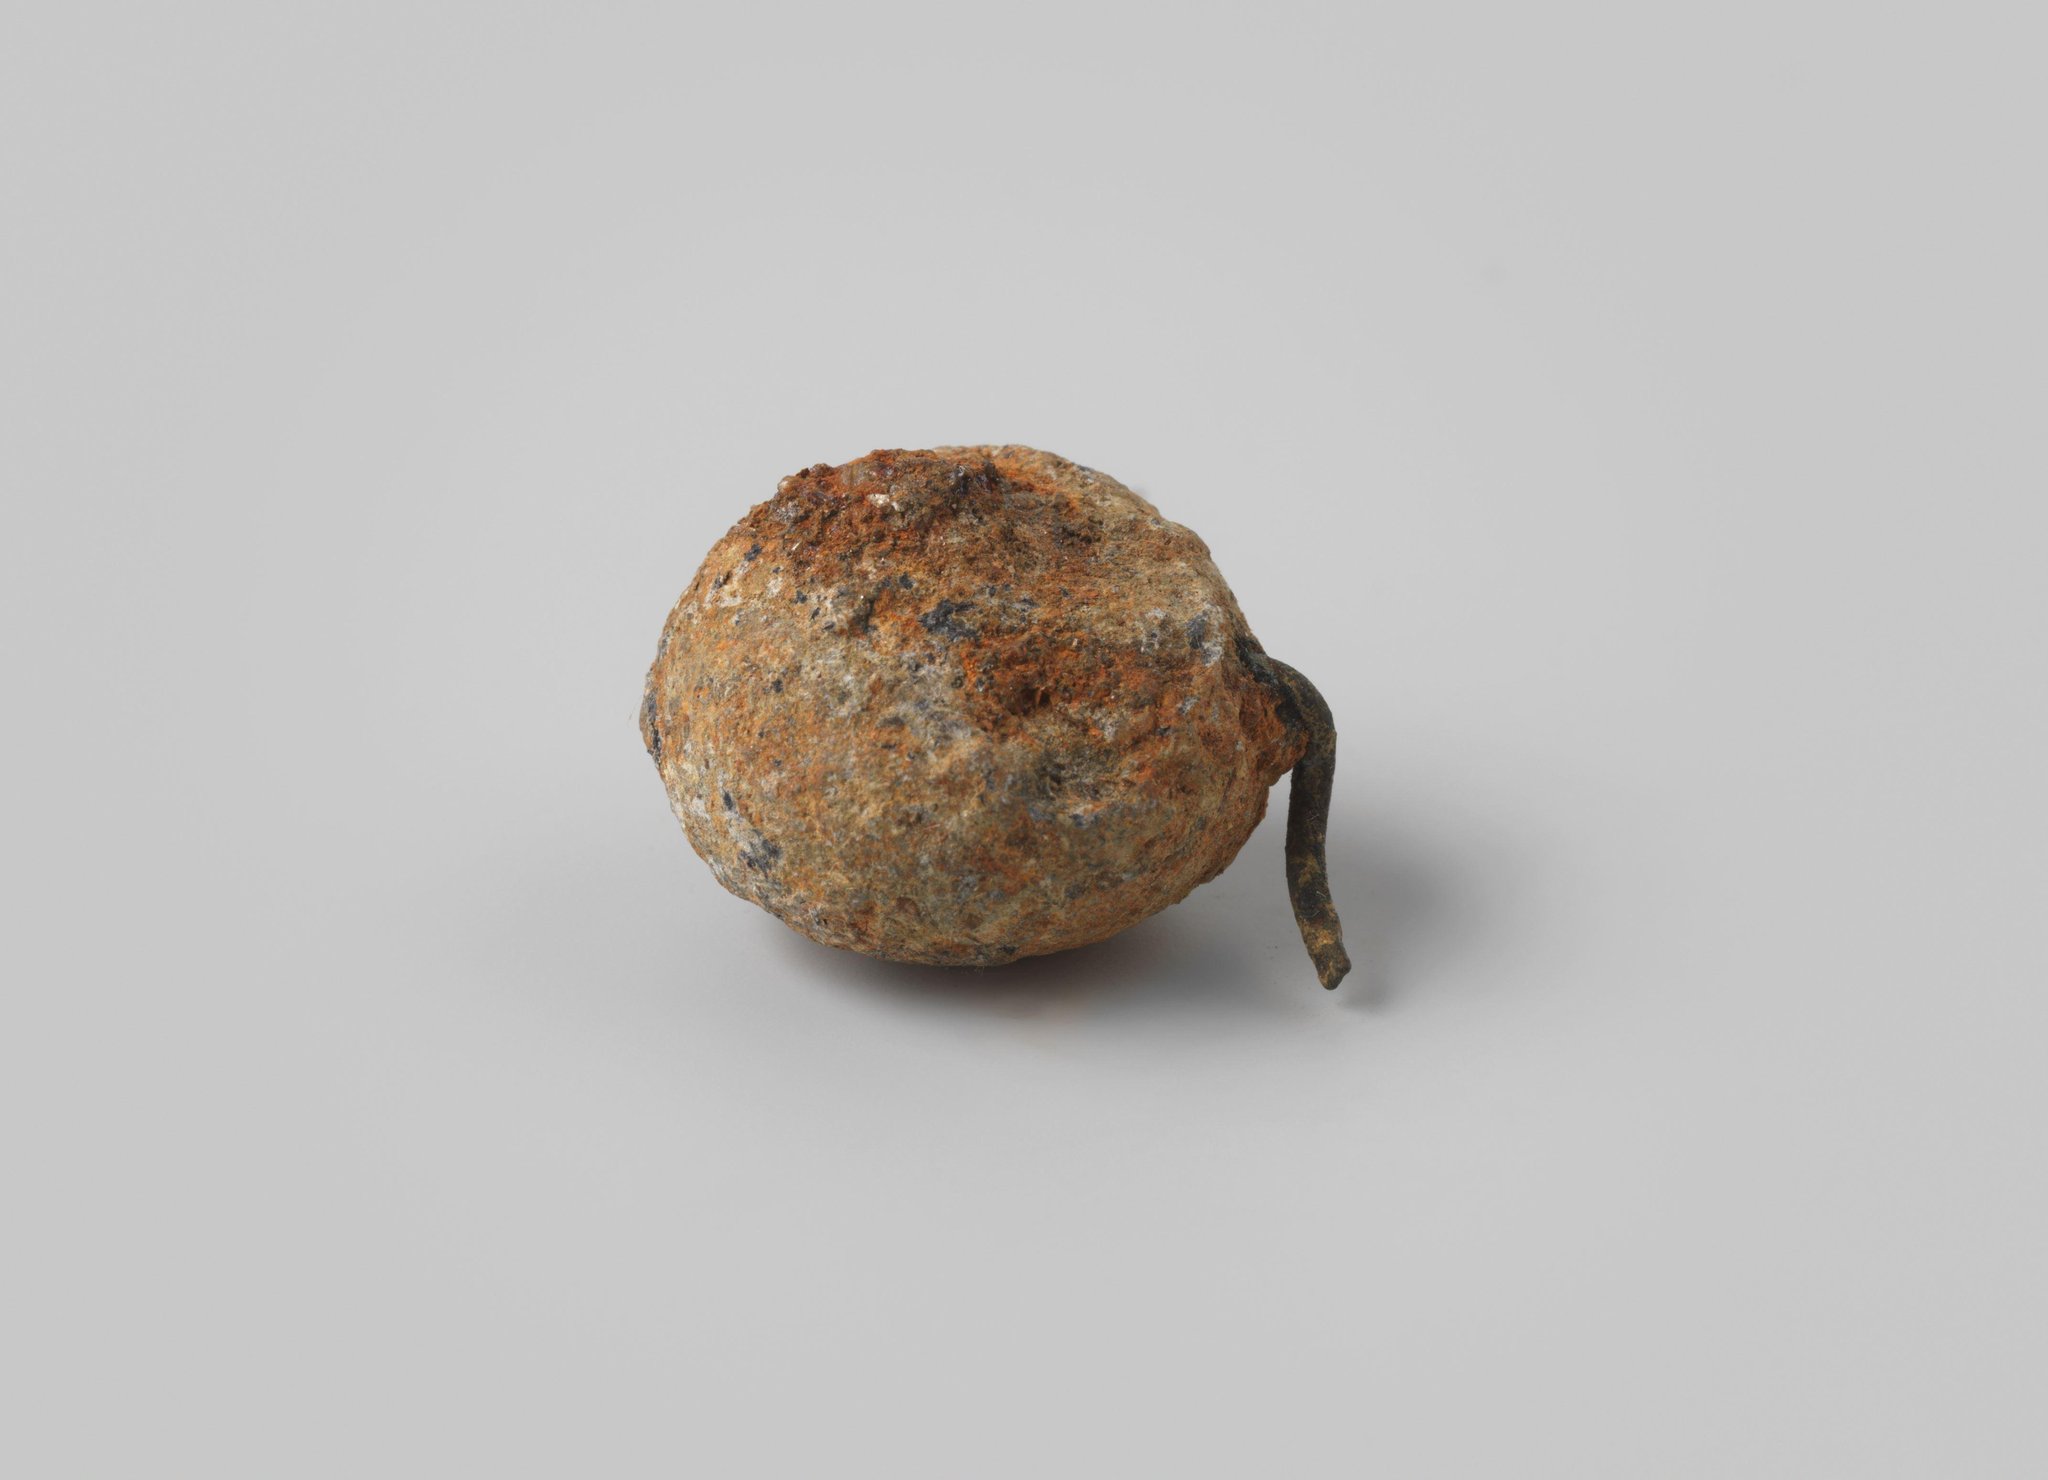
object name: chain shot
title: Kettingkogel uit het wrak van de Oost-Indiëvaarder Hollandia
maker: Anonymous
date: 1700-1743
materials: lead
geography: netherlands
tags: verenigde oostindische compagnie, hollandia (schip), annet